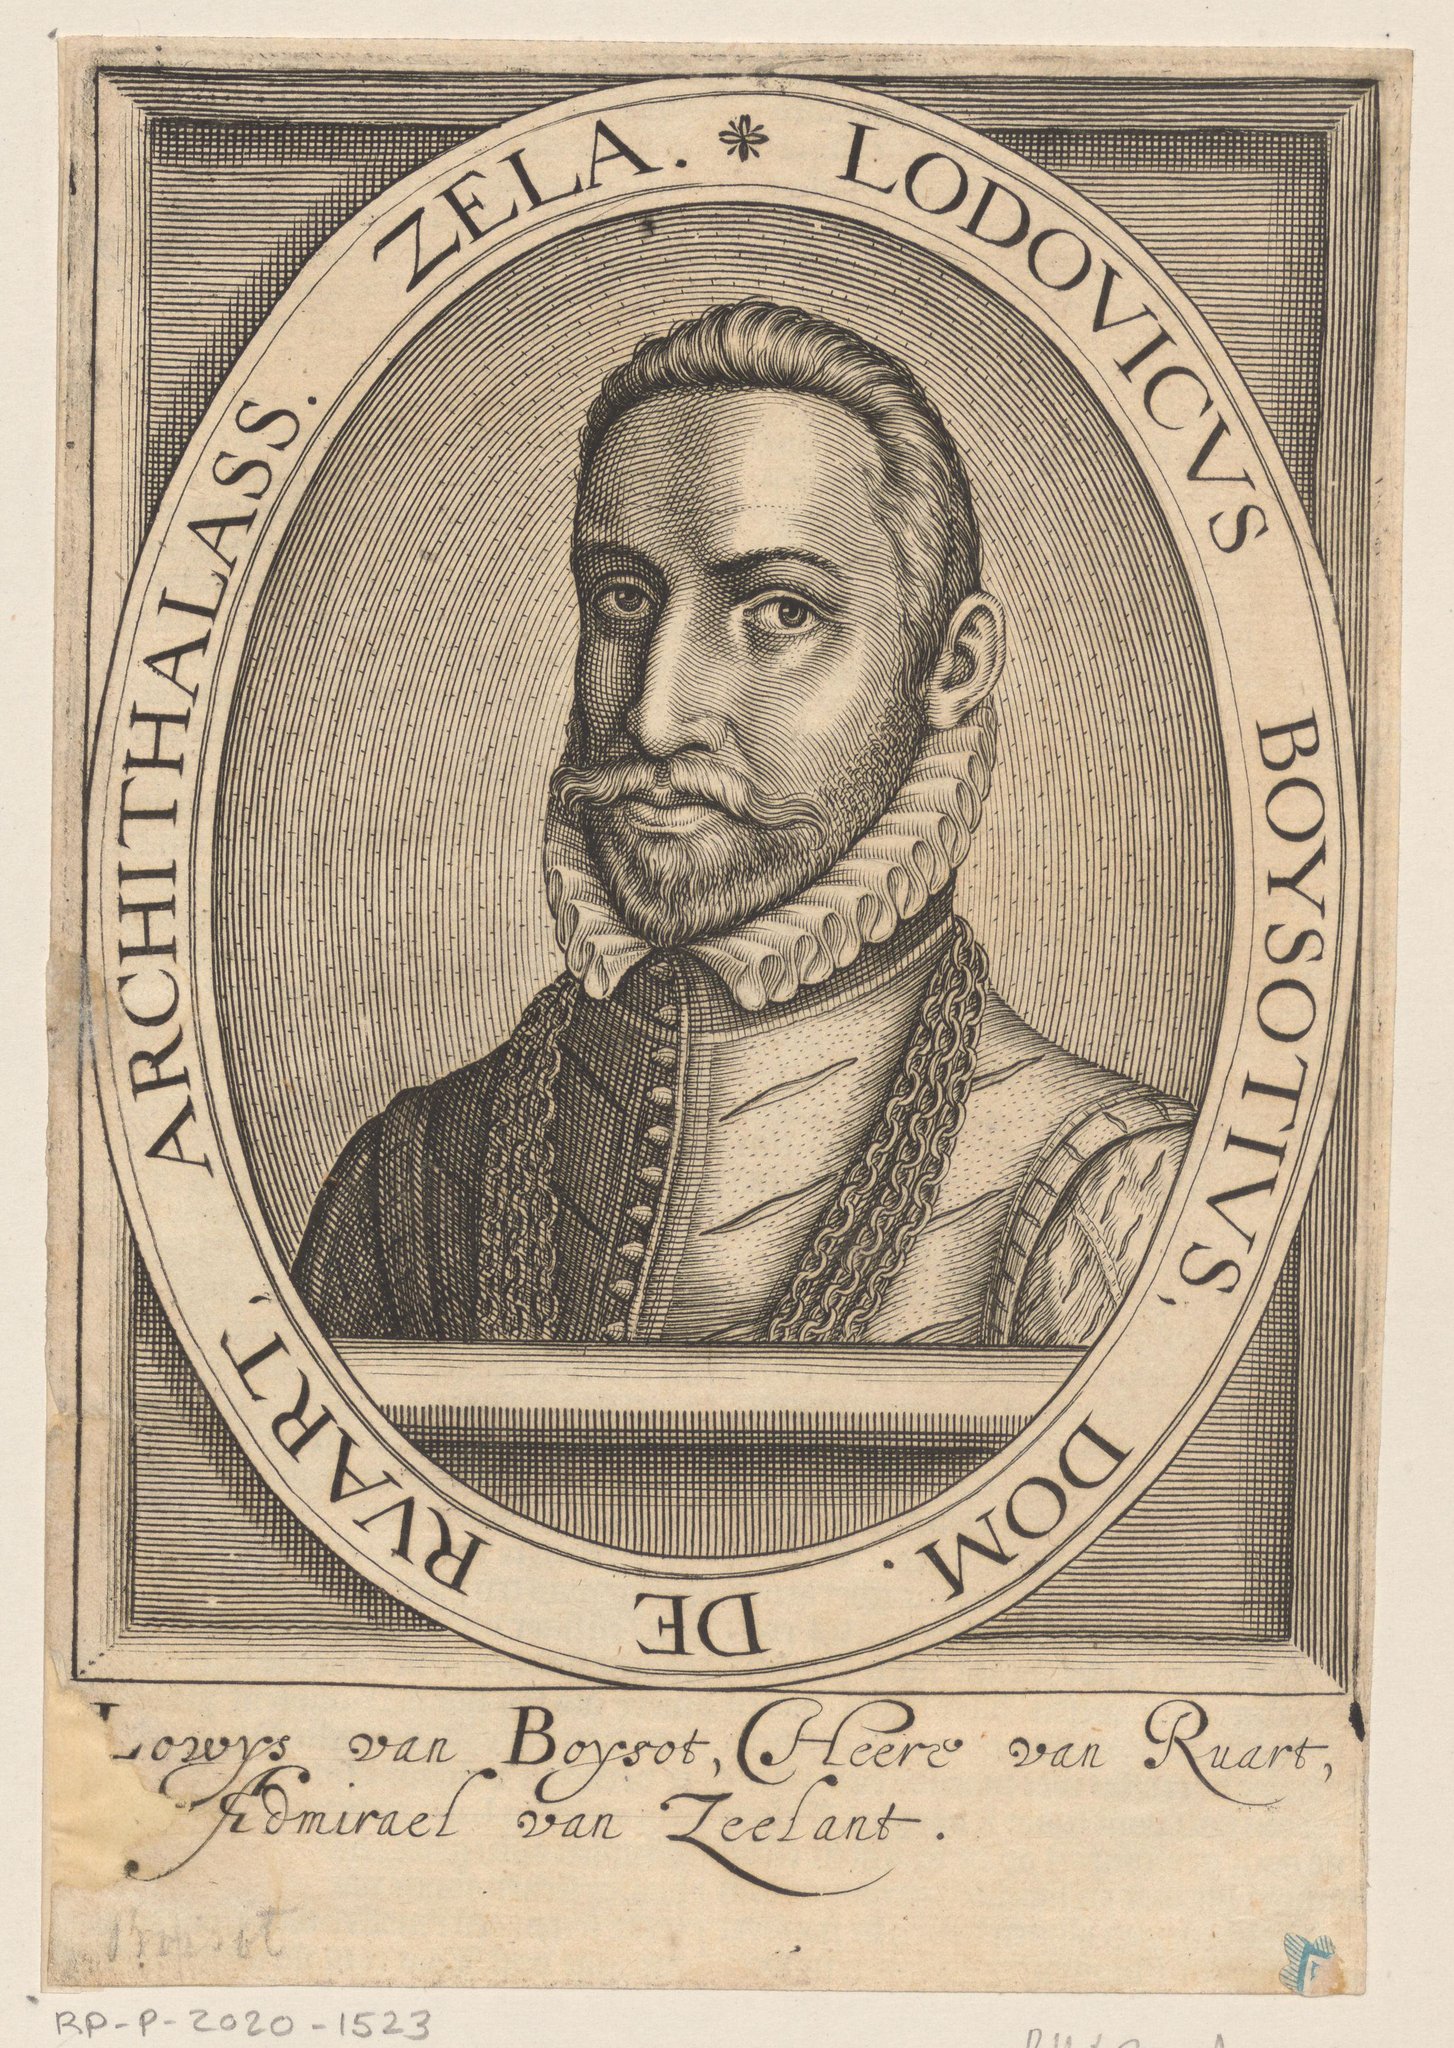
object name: print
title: Portret van Louis de Boisot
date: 1614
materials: paper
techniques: engraving, letterpress printing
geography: the hague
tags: brussels, historical persons, officer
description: Prent uit: Meteren, Emanuel van. Historie der Nederlandscher ende haerder na-buren oorlogen ende geschiedenissen (...). Den Haag: Hillebrant Jacobsz. van Wouw, 1614, f. 103. Prent ook gebruikt in latere edities van dit werk.